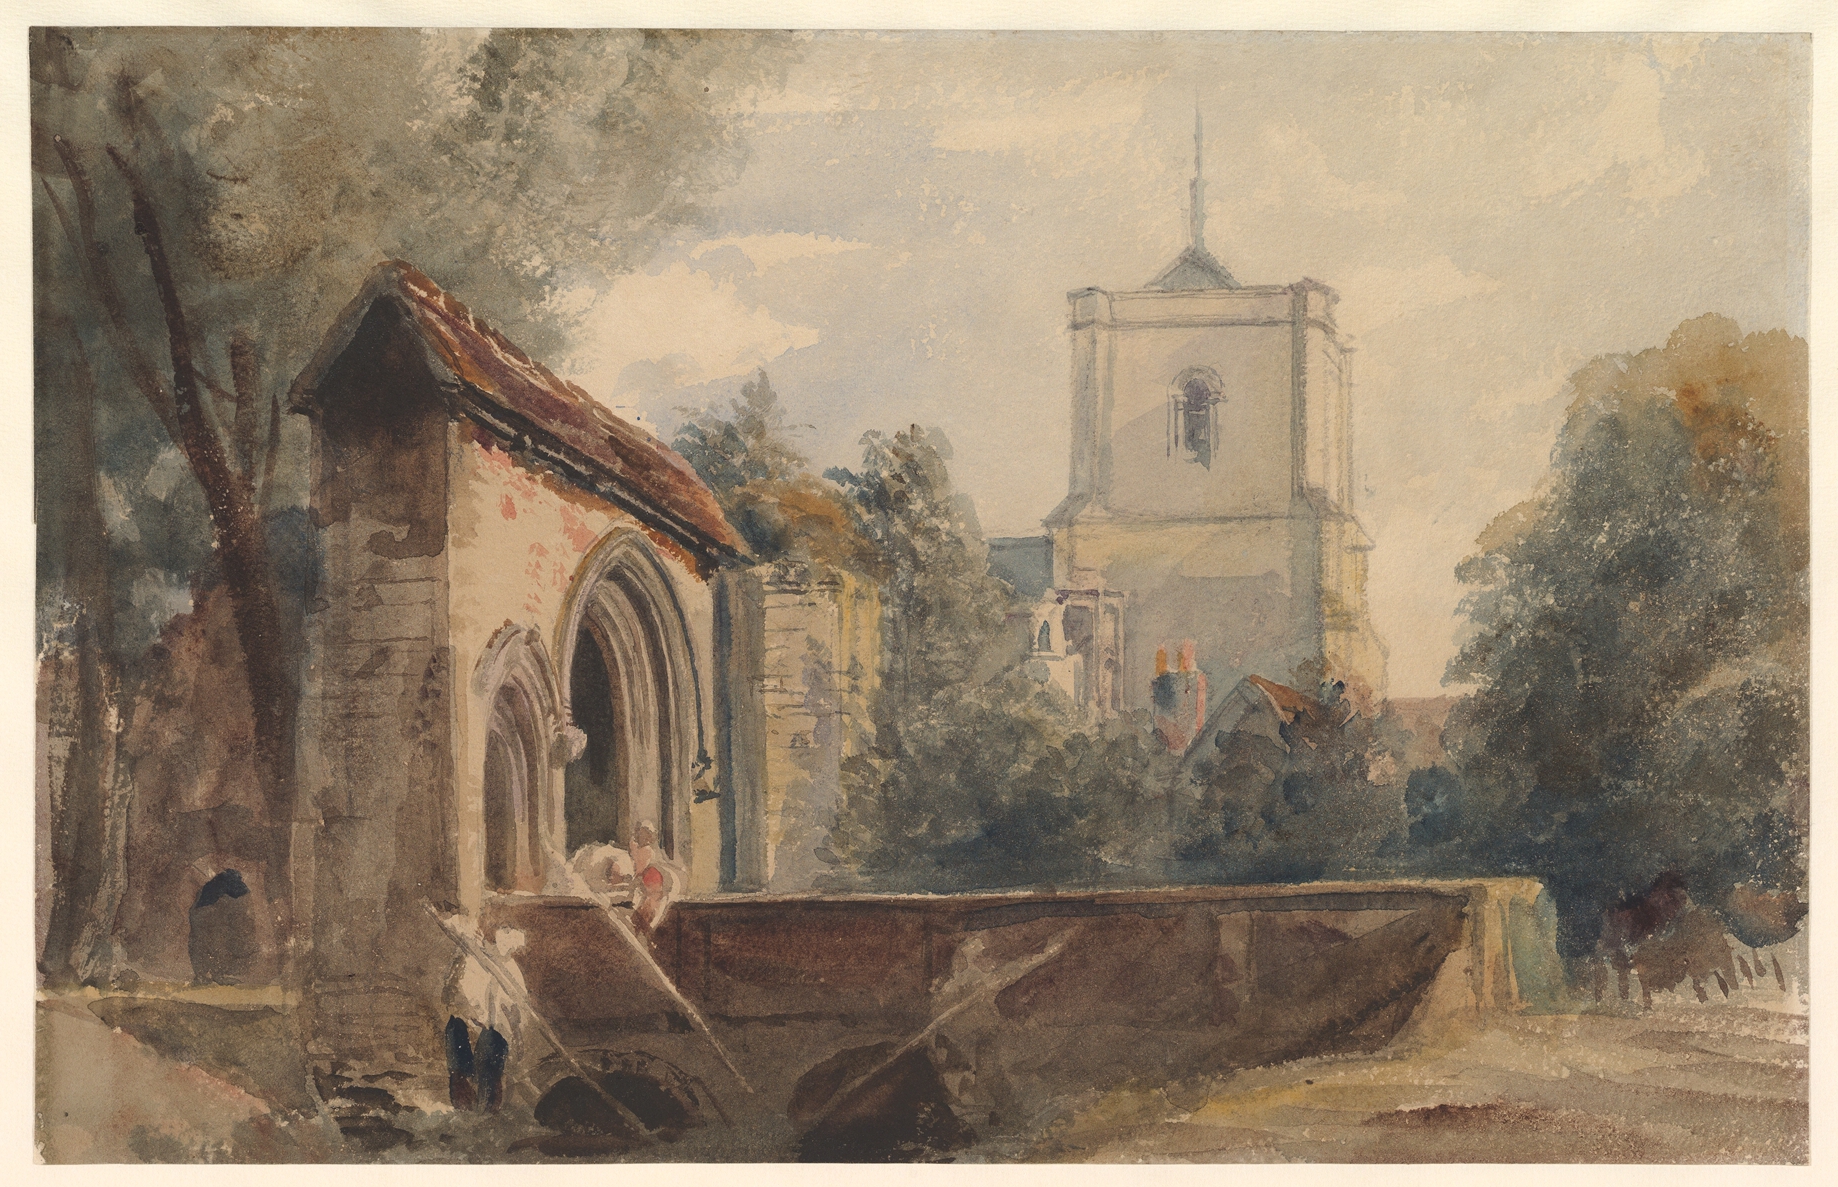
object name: drawing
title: Waltham Abbey, Essex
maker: peter de wint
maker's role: artist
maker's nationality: british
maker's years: 1784-1849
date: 1840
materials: graphite, watercolor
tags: abbeys,landscapes